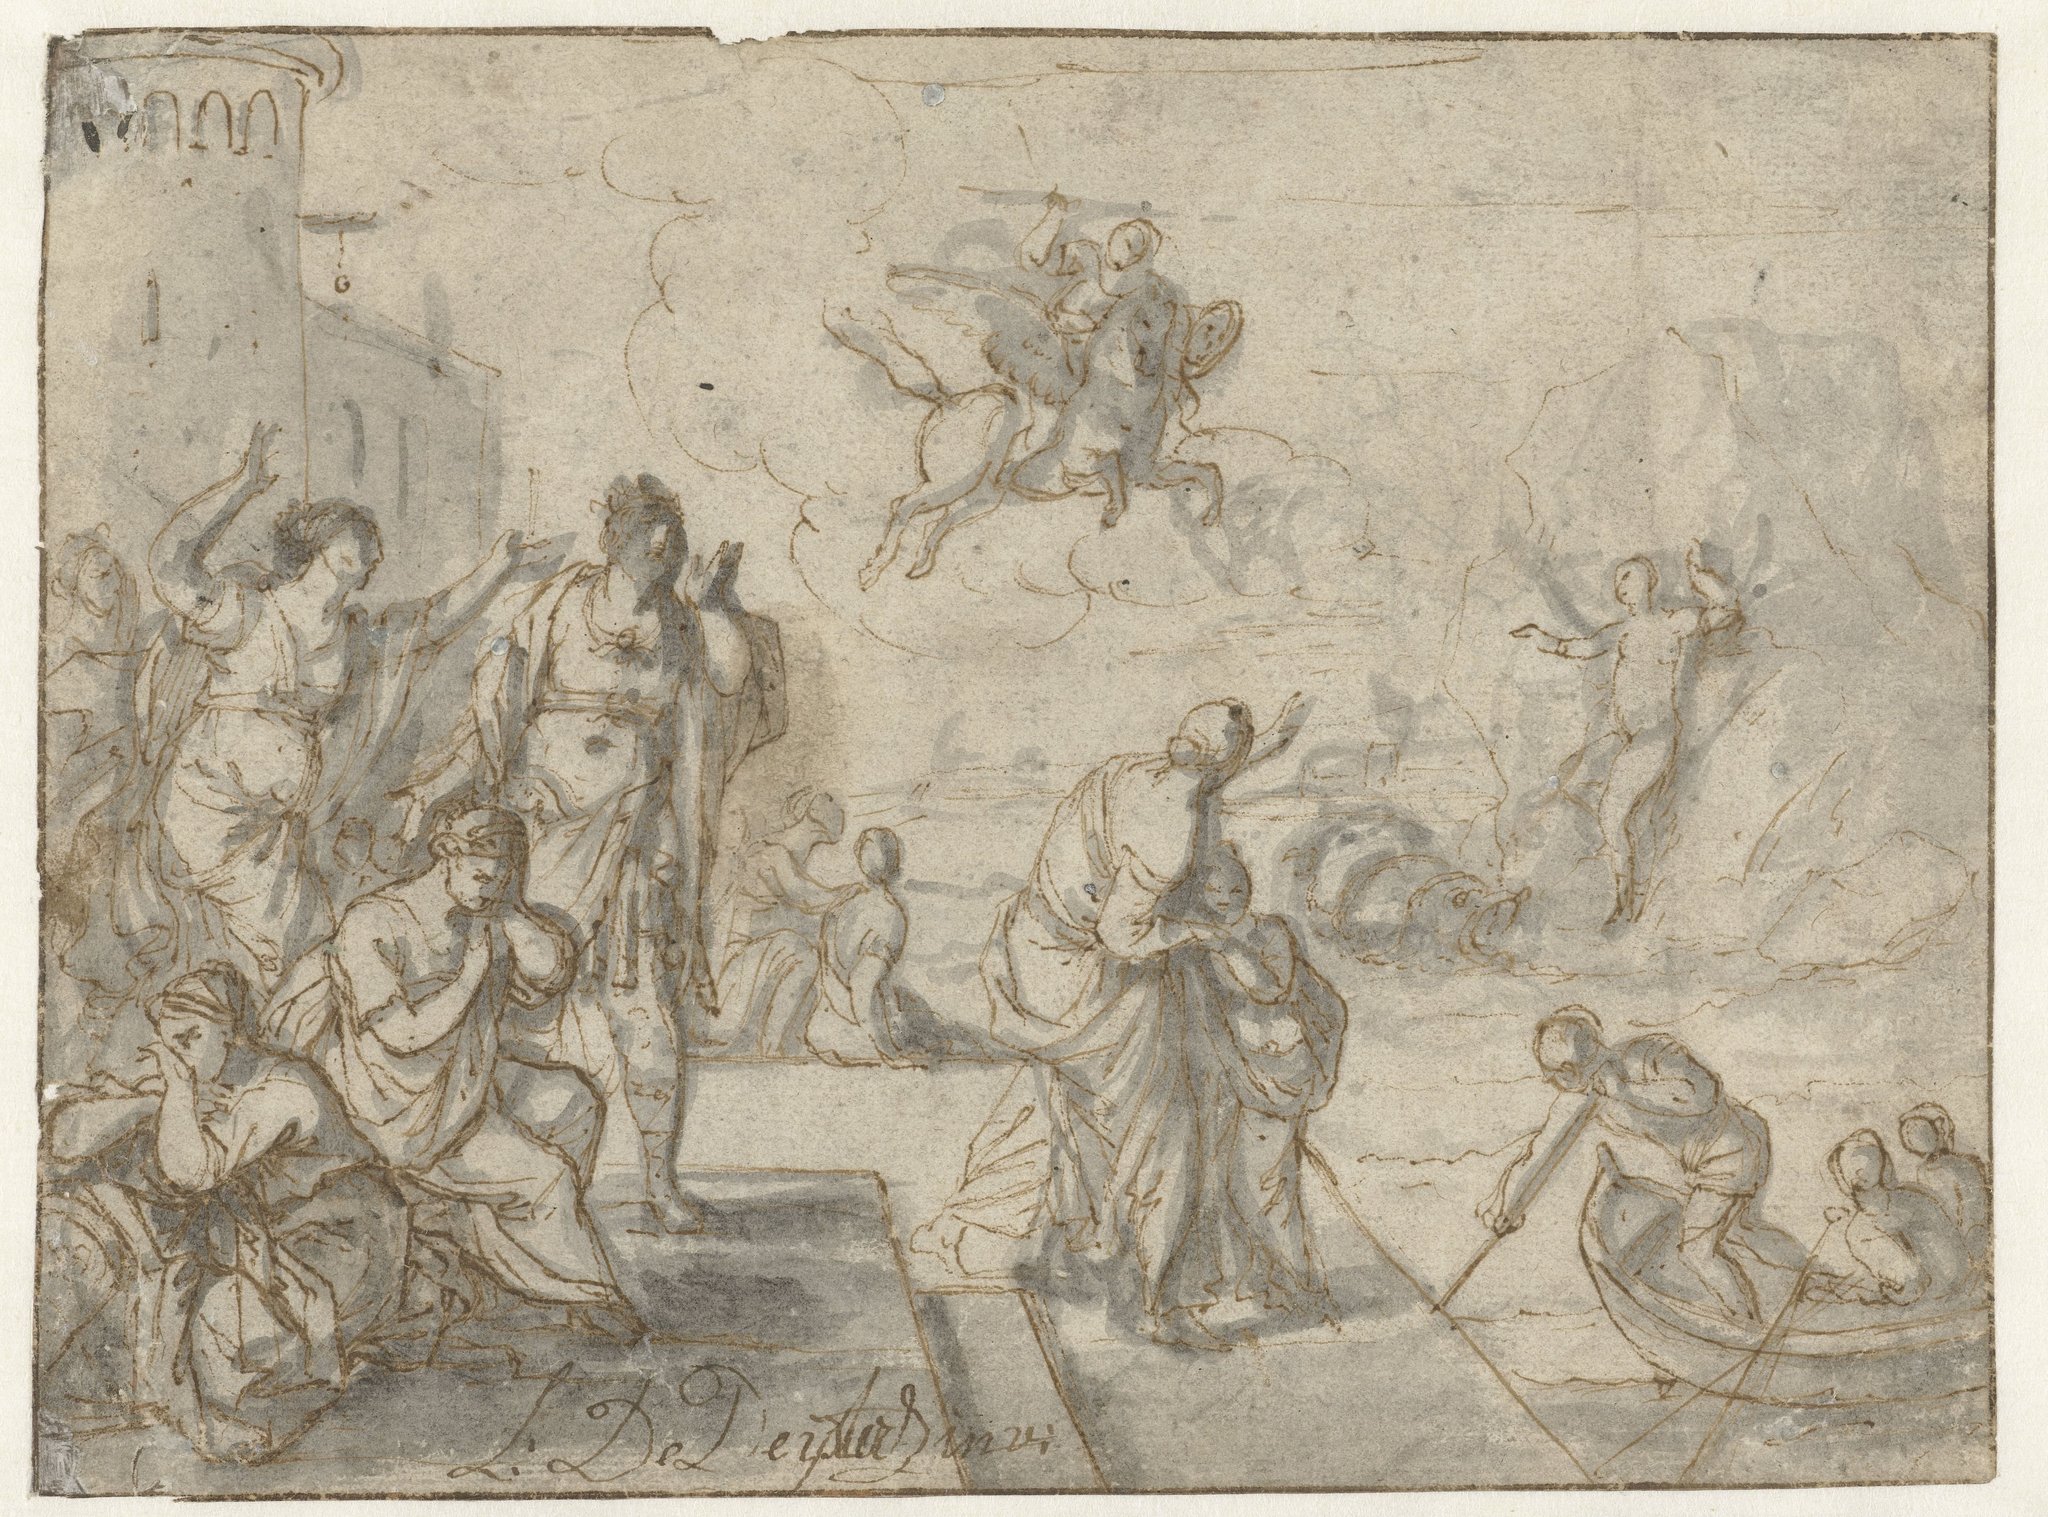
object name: drawing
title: Perseus en Andromeda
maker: louis de deyster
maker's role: draughtsman, painter, print maker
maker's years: 1656-1711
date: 1666-1711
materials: ink, paper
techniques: brush, pen